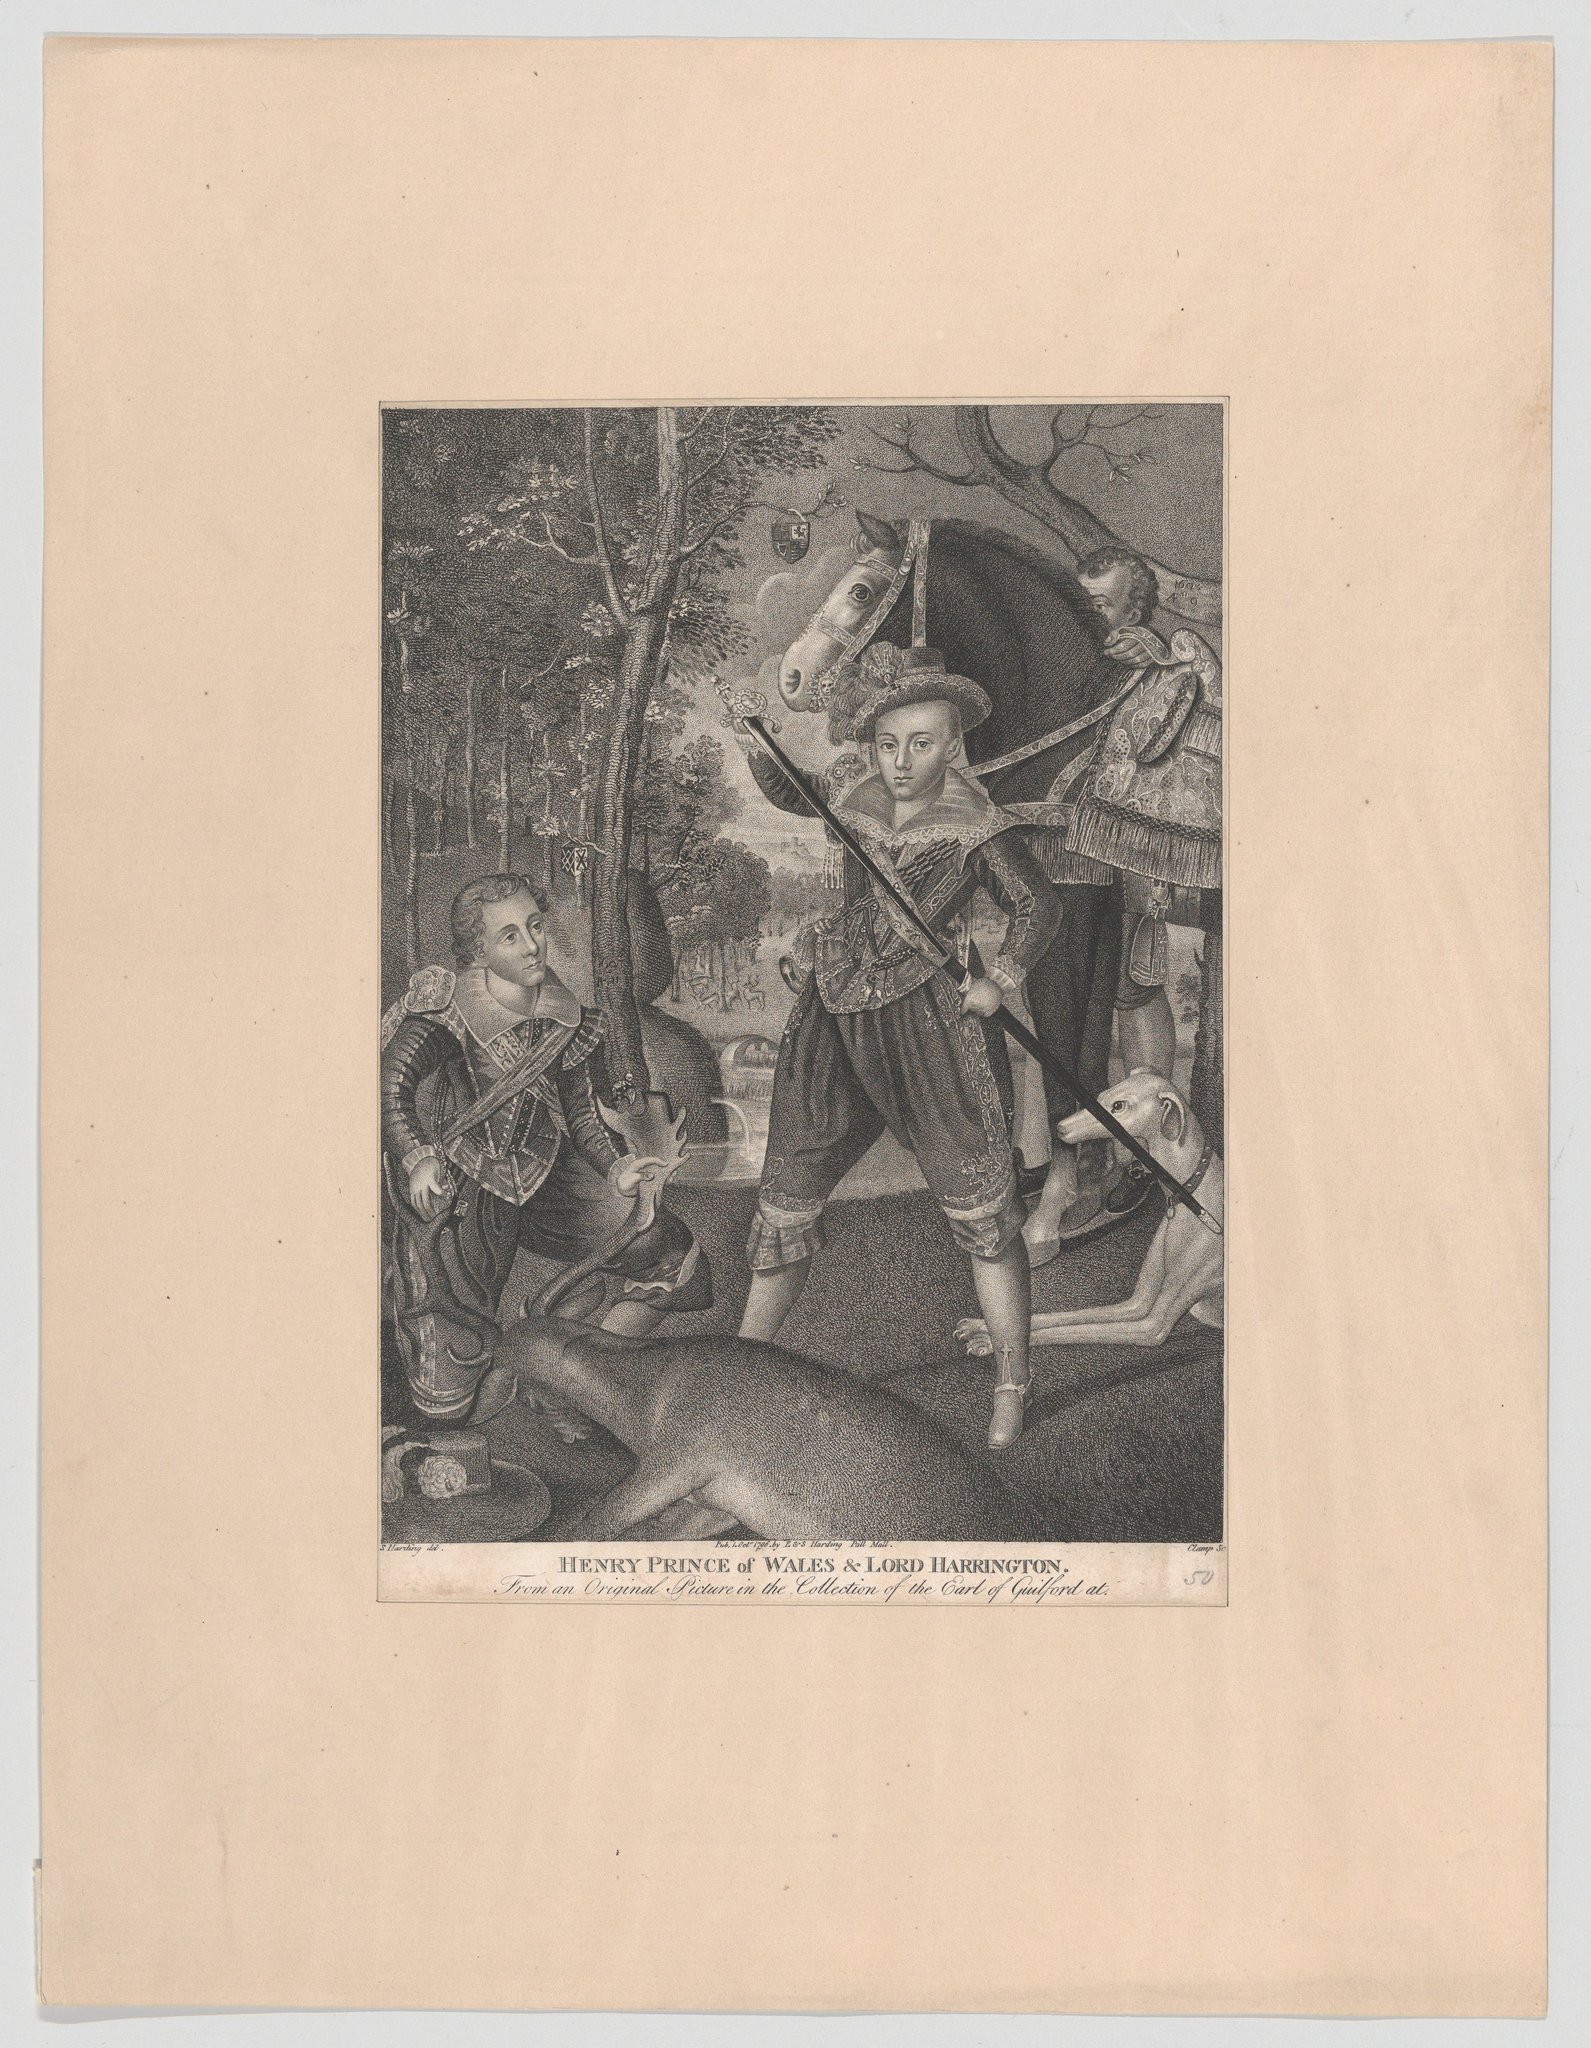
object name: print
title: Henry Frederick, Prince of Wales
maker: r. clamp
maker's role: engraver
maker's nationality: british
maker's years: 1788-1798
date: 1796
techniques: etching, stippling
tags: swords,princes,men,hunting,deer,dogs,horses,forests